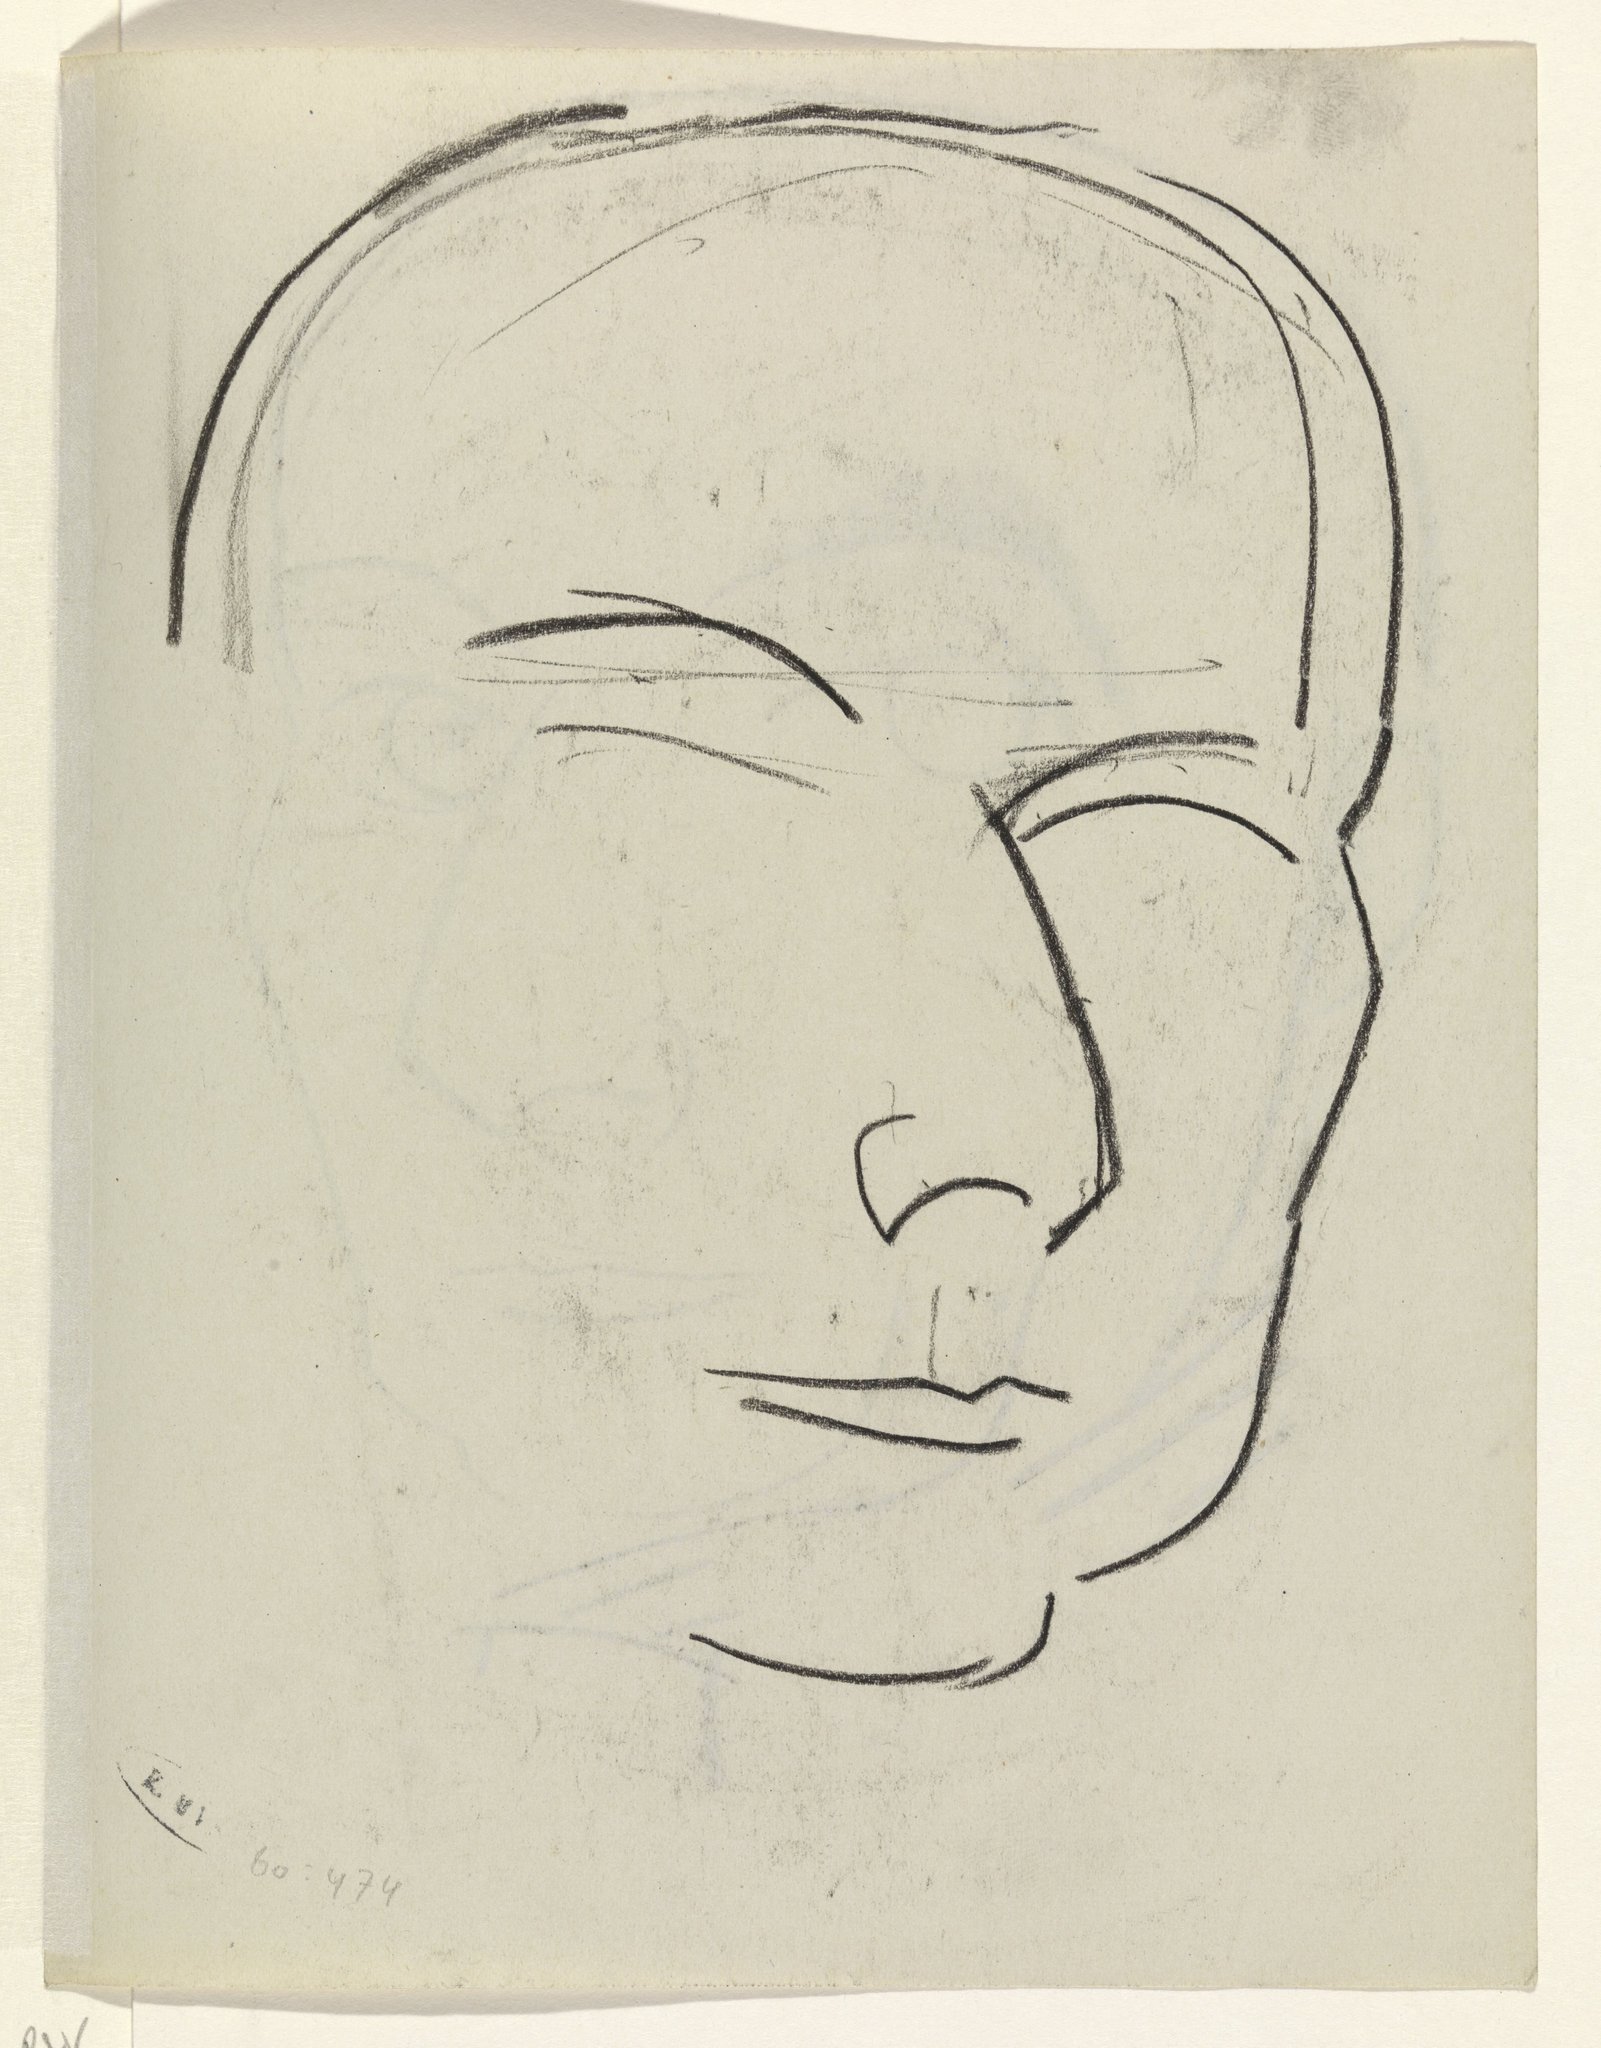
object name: drawing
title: Zelfportret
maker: leo gestel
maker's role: draughtsman, print maker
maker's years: 1881-1941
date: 1891-1941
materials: chalk, paper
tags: draughtsman, leo gestel, portrait, self-portrait of painter, male sex; man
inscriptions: collector's mark: Lugt 2228